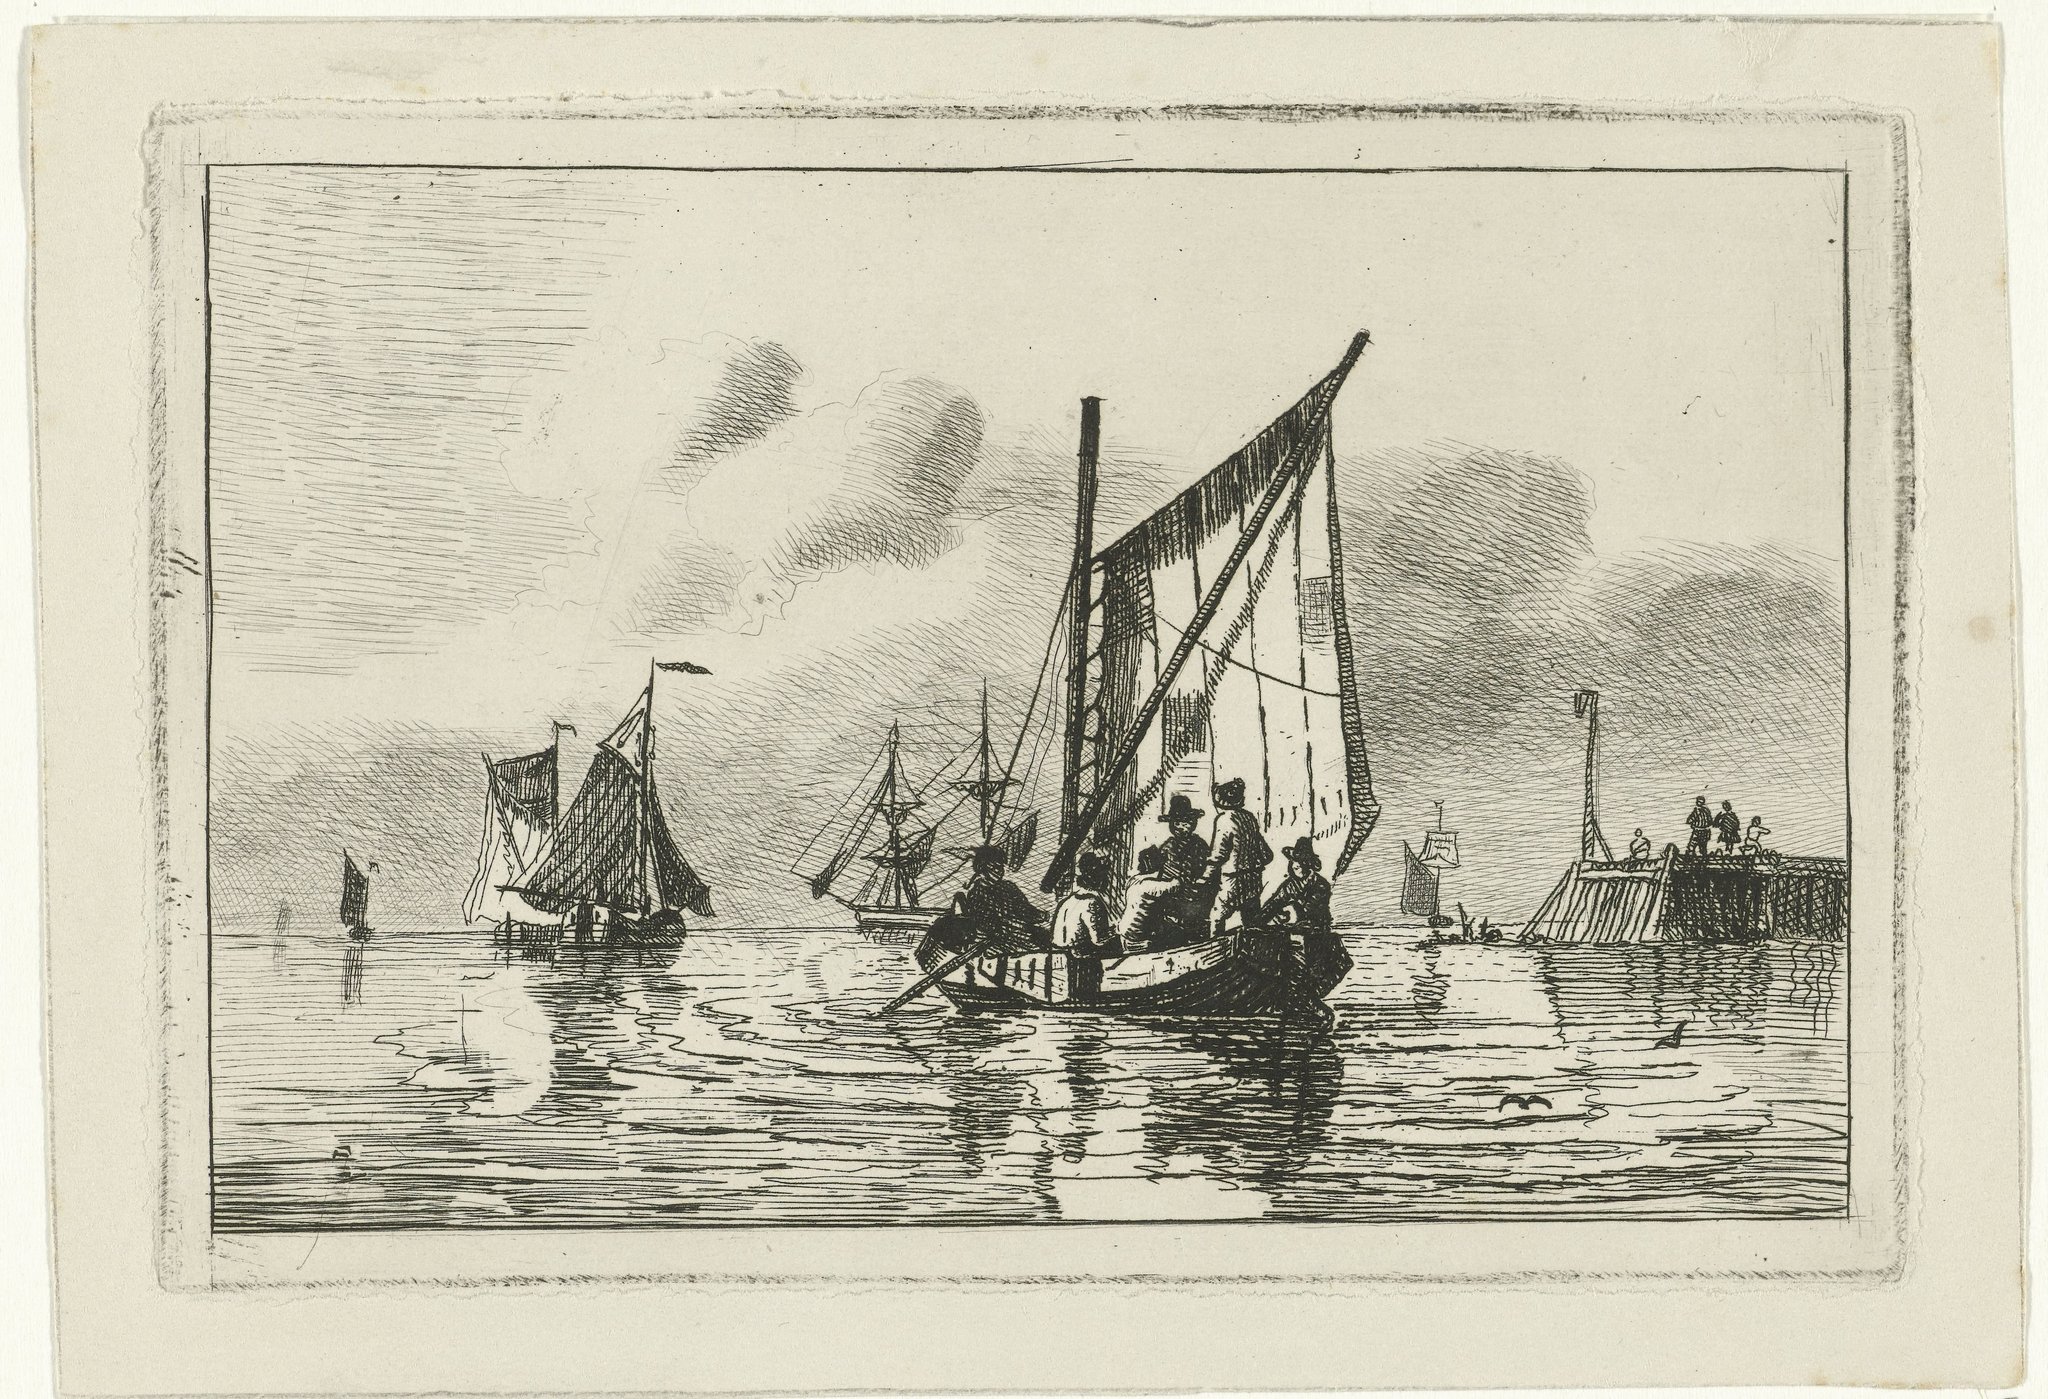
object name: print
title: Visserspink met zes personen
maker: willem gruyter jr.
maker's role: draughtsman, print maker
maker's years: 1817-1880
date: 1832-1880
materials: paper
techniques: engraving, etching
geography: amsterdam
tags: rowing-boat, canoe, etc. (+ view ~ vehicle, ship, etc.)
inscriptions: collector's mark: Lugt 2165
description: Een visserspink met zes mannen, op de achtergrond zeilschepen, rechts een pier.